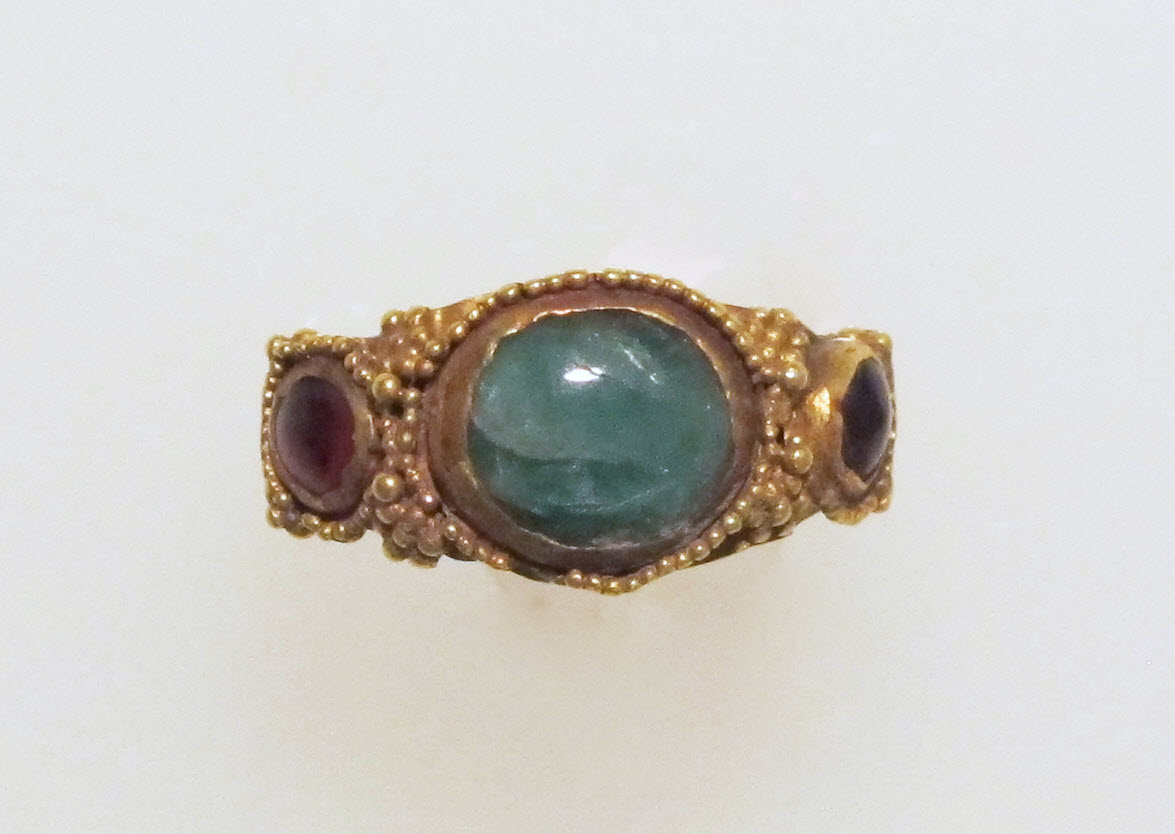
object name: ring, filigree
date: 7000 BCE-330 CE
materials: gemstone, gold